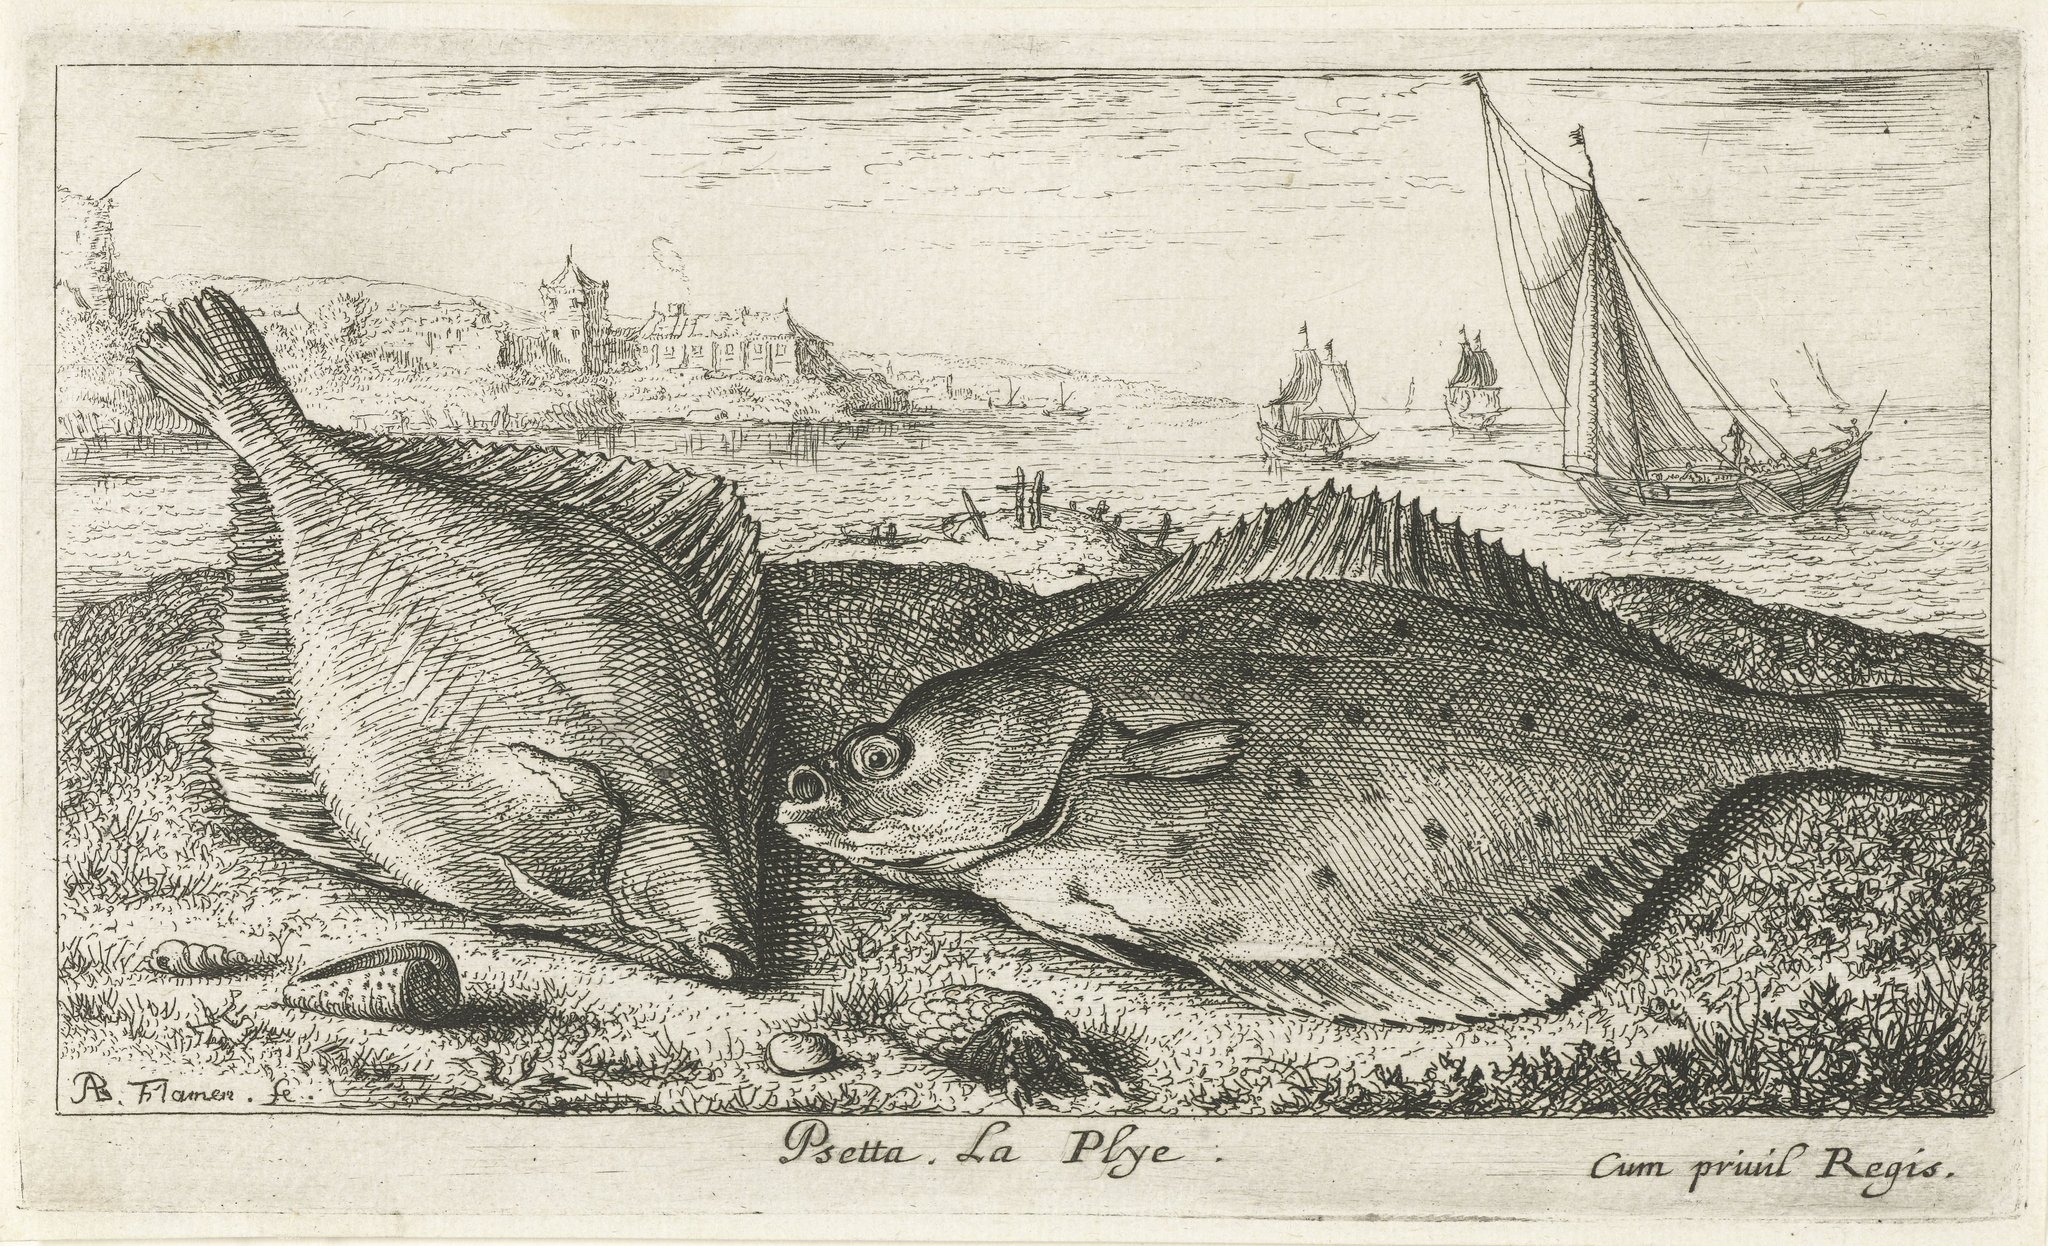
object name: print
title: Poissons de mer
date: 1664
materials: paper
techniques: etching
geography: paris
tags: fishes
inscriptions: collector's mark: Lugt 2228